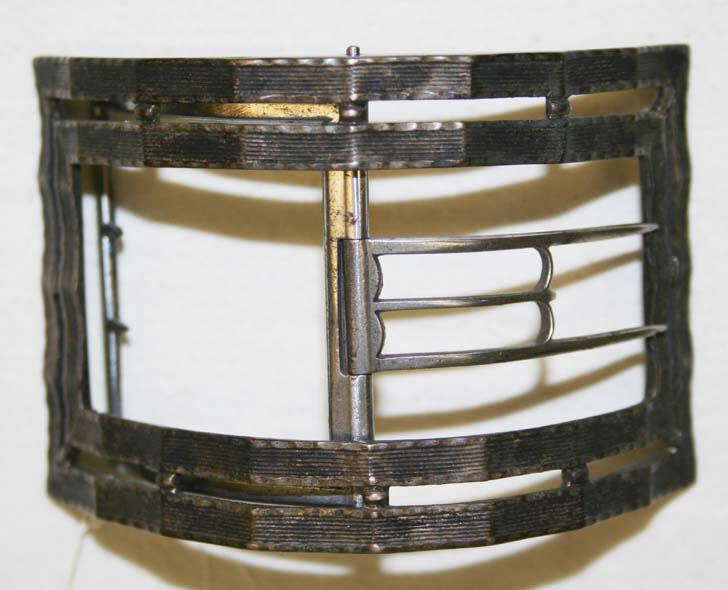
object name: shoe buckle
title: Shoe buckles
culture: british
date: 1784-1785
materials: silver